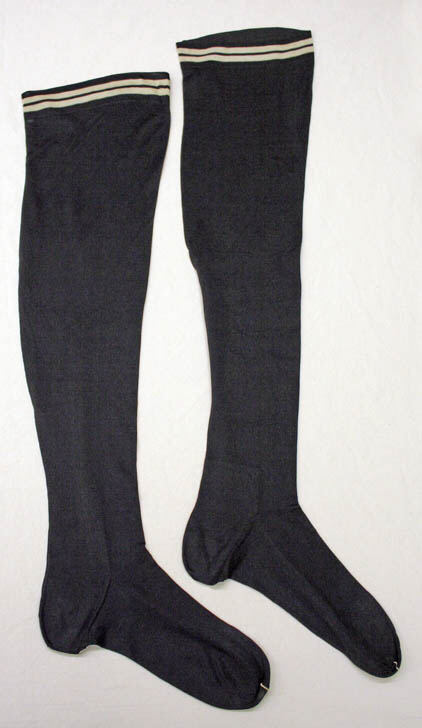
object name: stocking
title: Stockings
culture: american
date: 1897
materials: silk